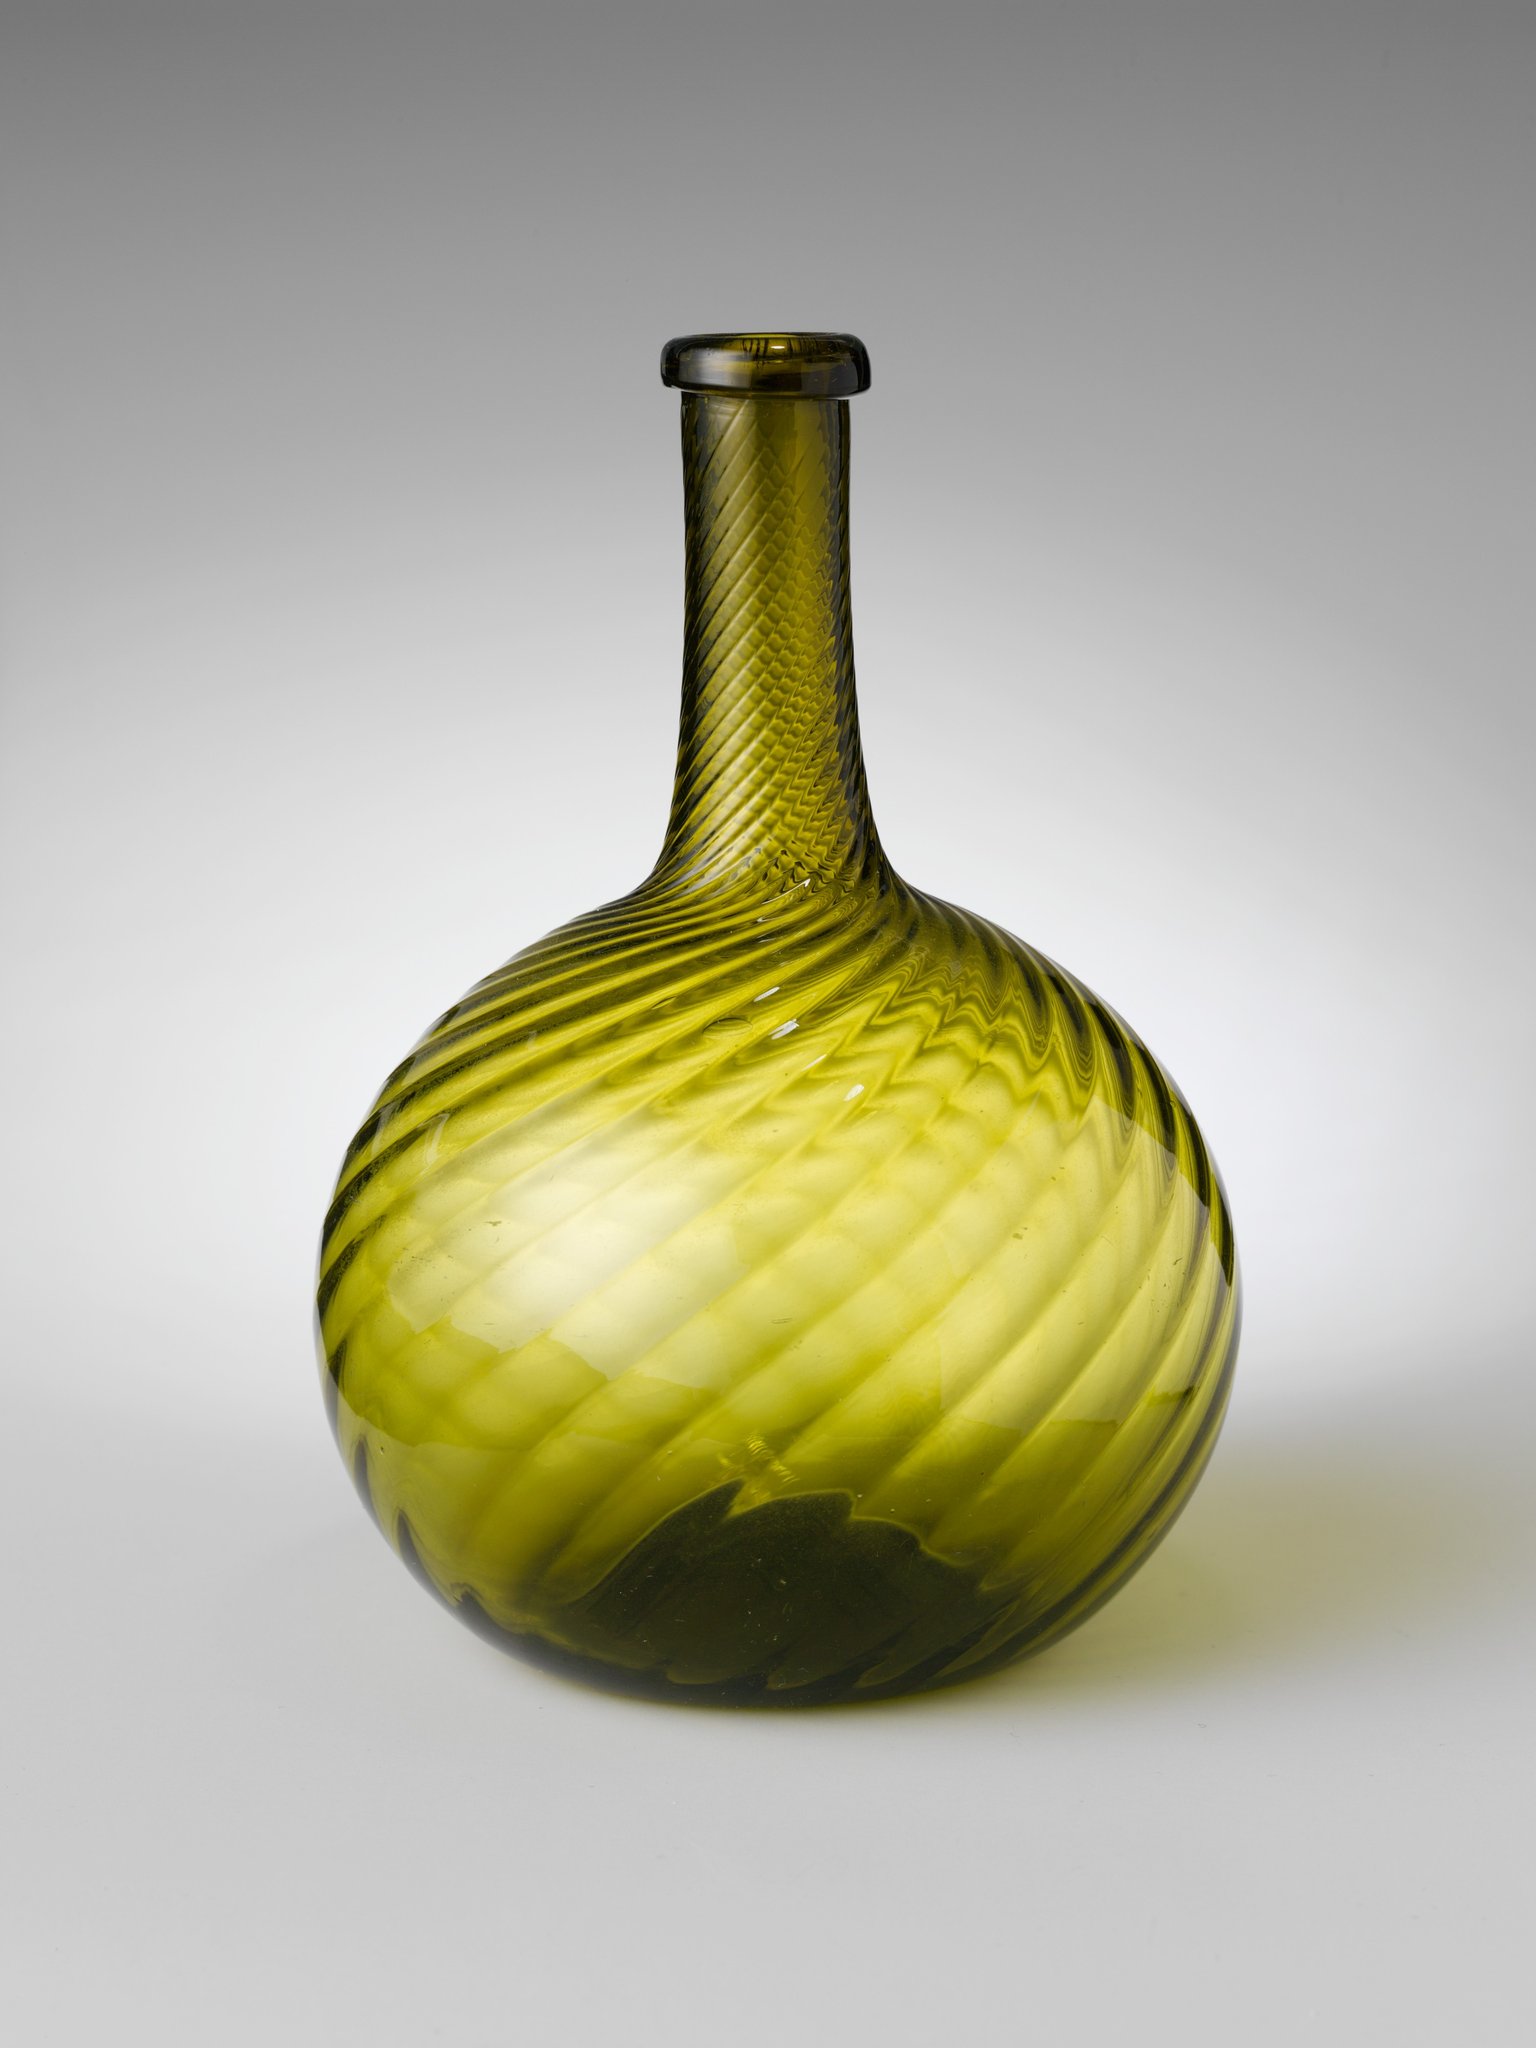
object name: bottle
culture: american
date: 1820-1840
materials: glass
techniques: glassblowing, molding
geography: united states